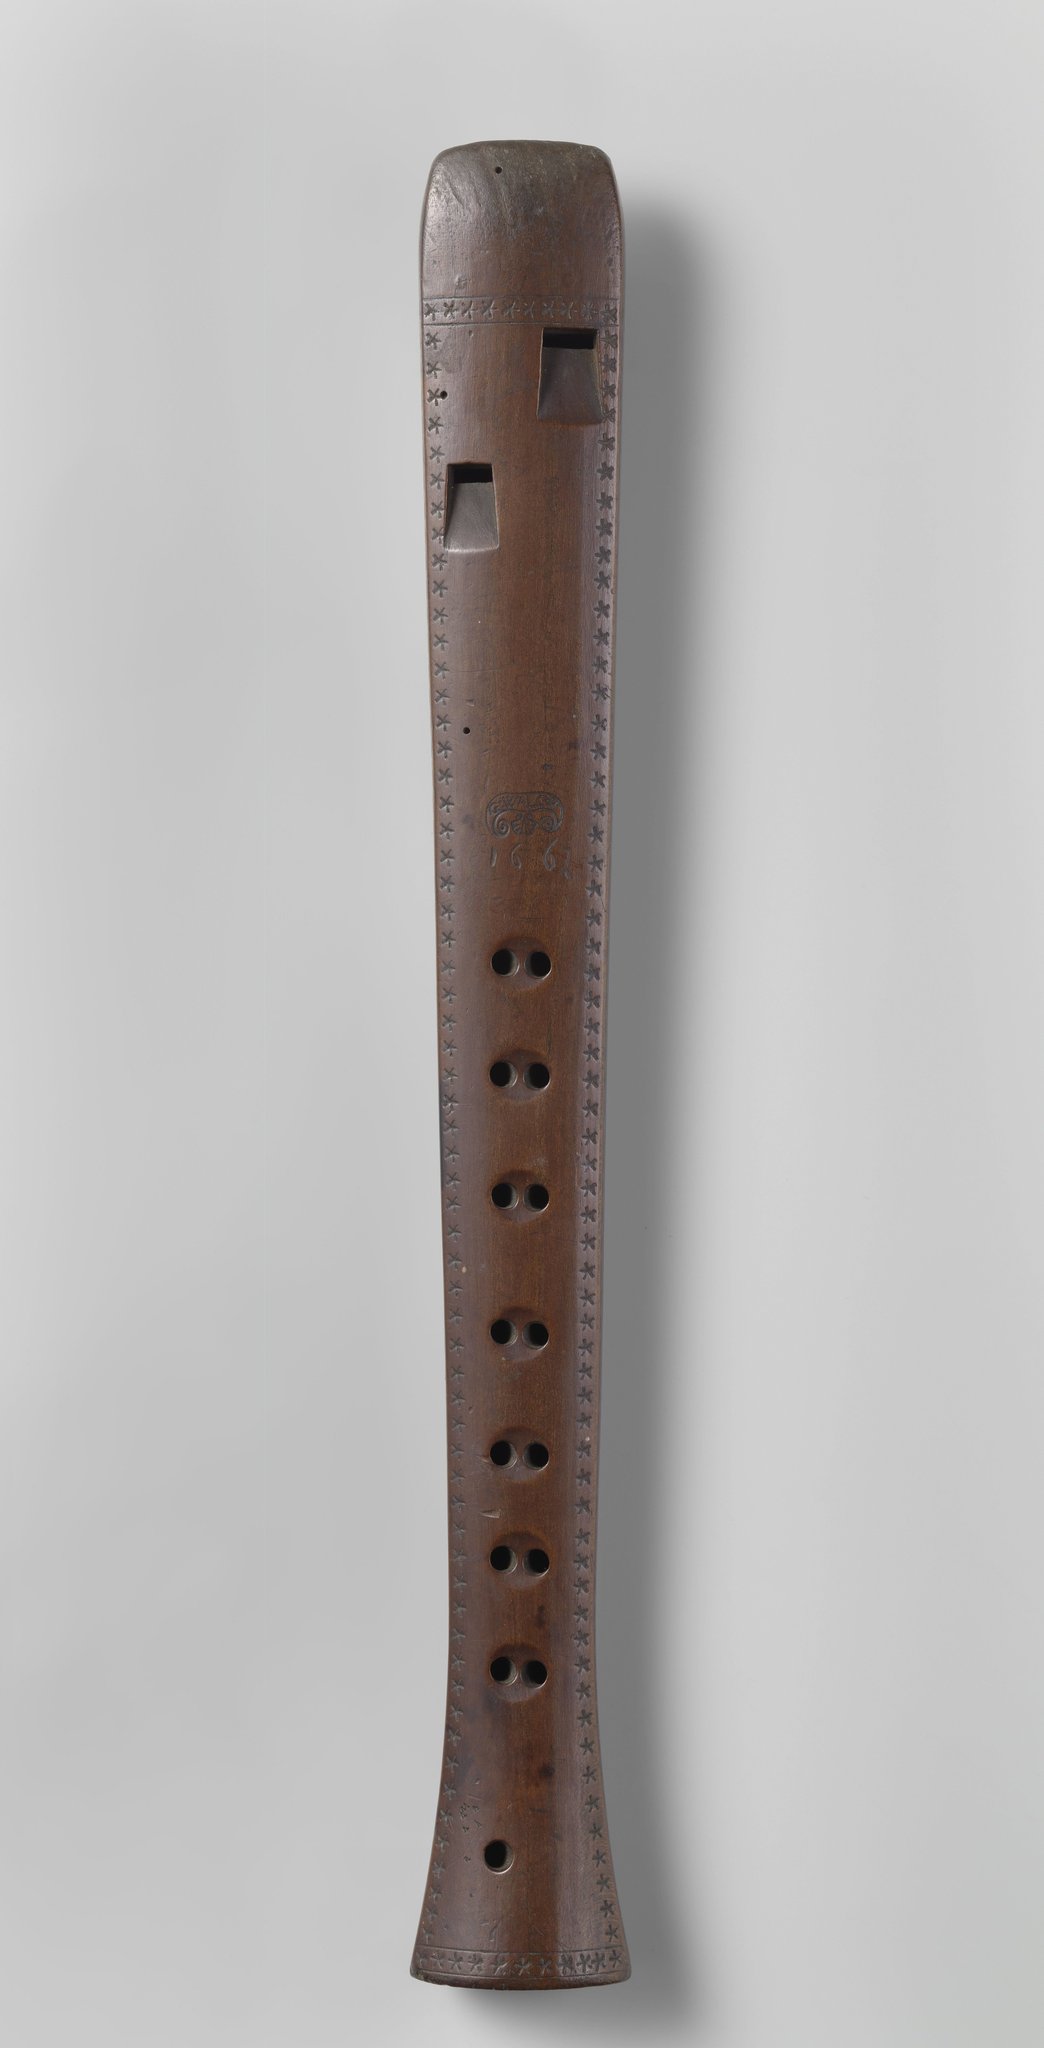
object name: flute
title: Double flute (flûte d’accord)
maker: georg walch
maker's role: musical instrument maker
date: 1662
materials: wood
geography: berchtesgaden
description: Akkoordfluit ook wel dubbelfluit of harmonische fluit genoemd. In 1662 vervaardigd door G. WALCH.